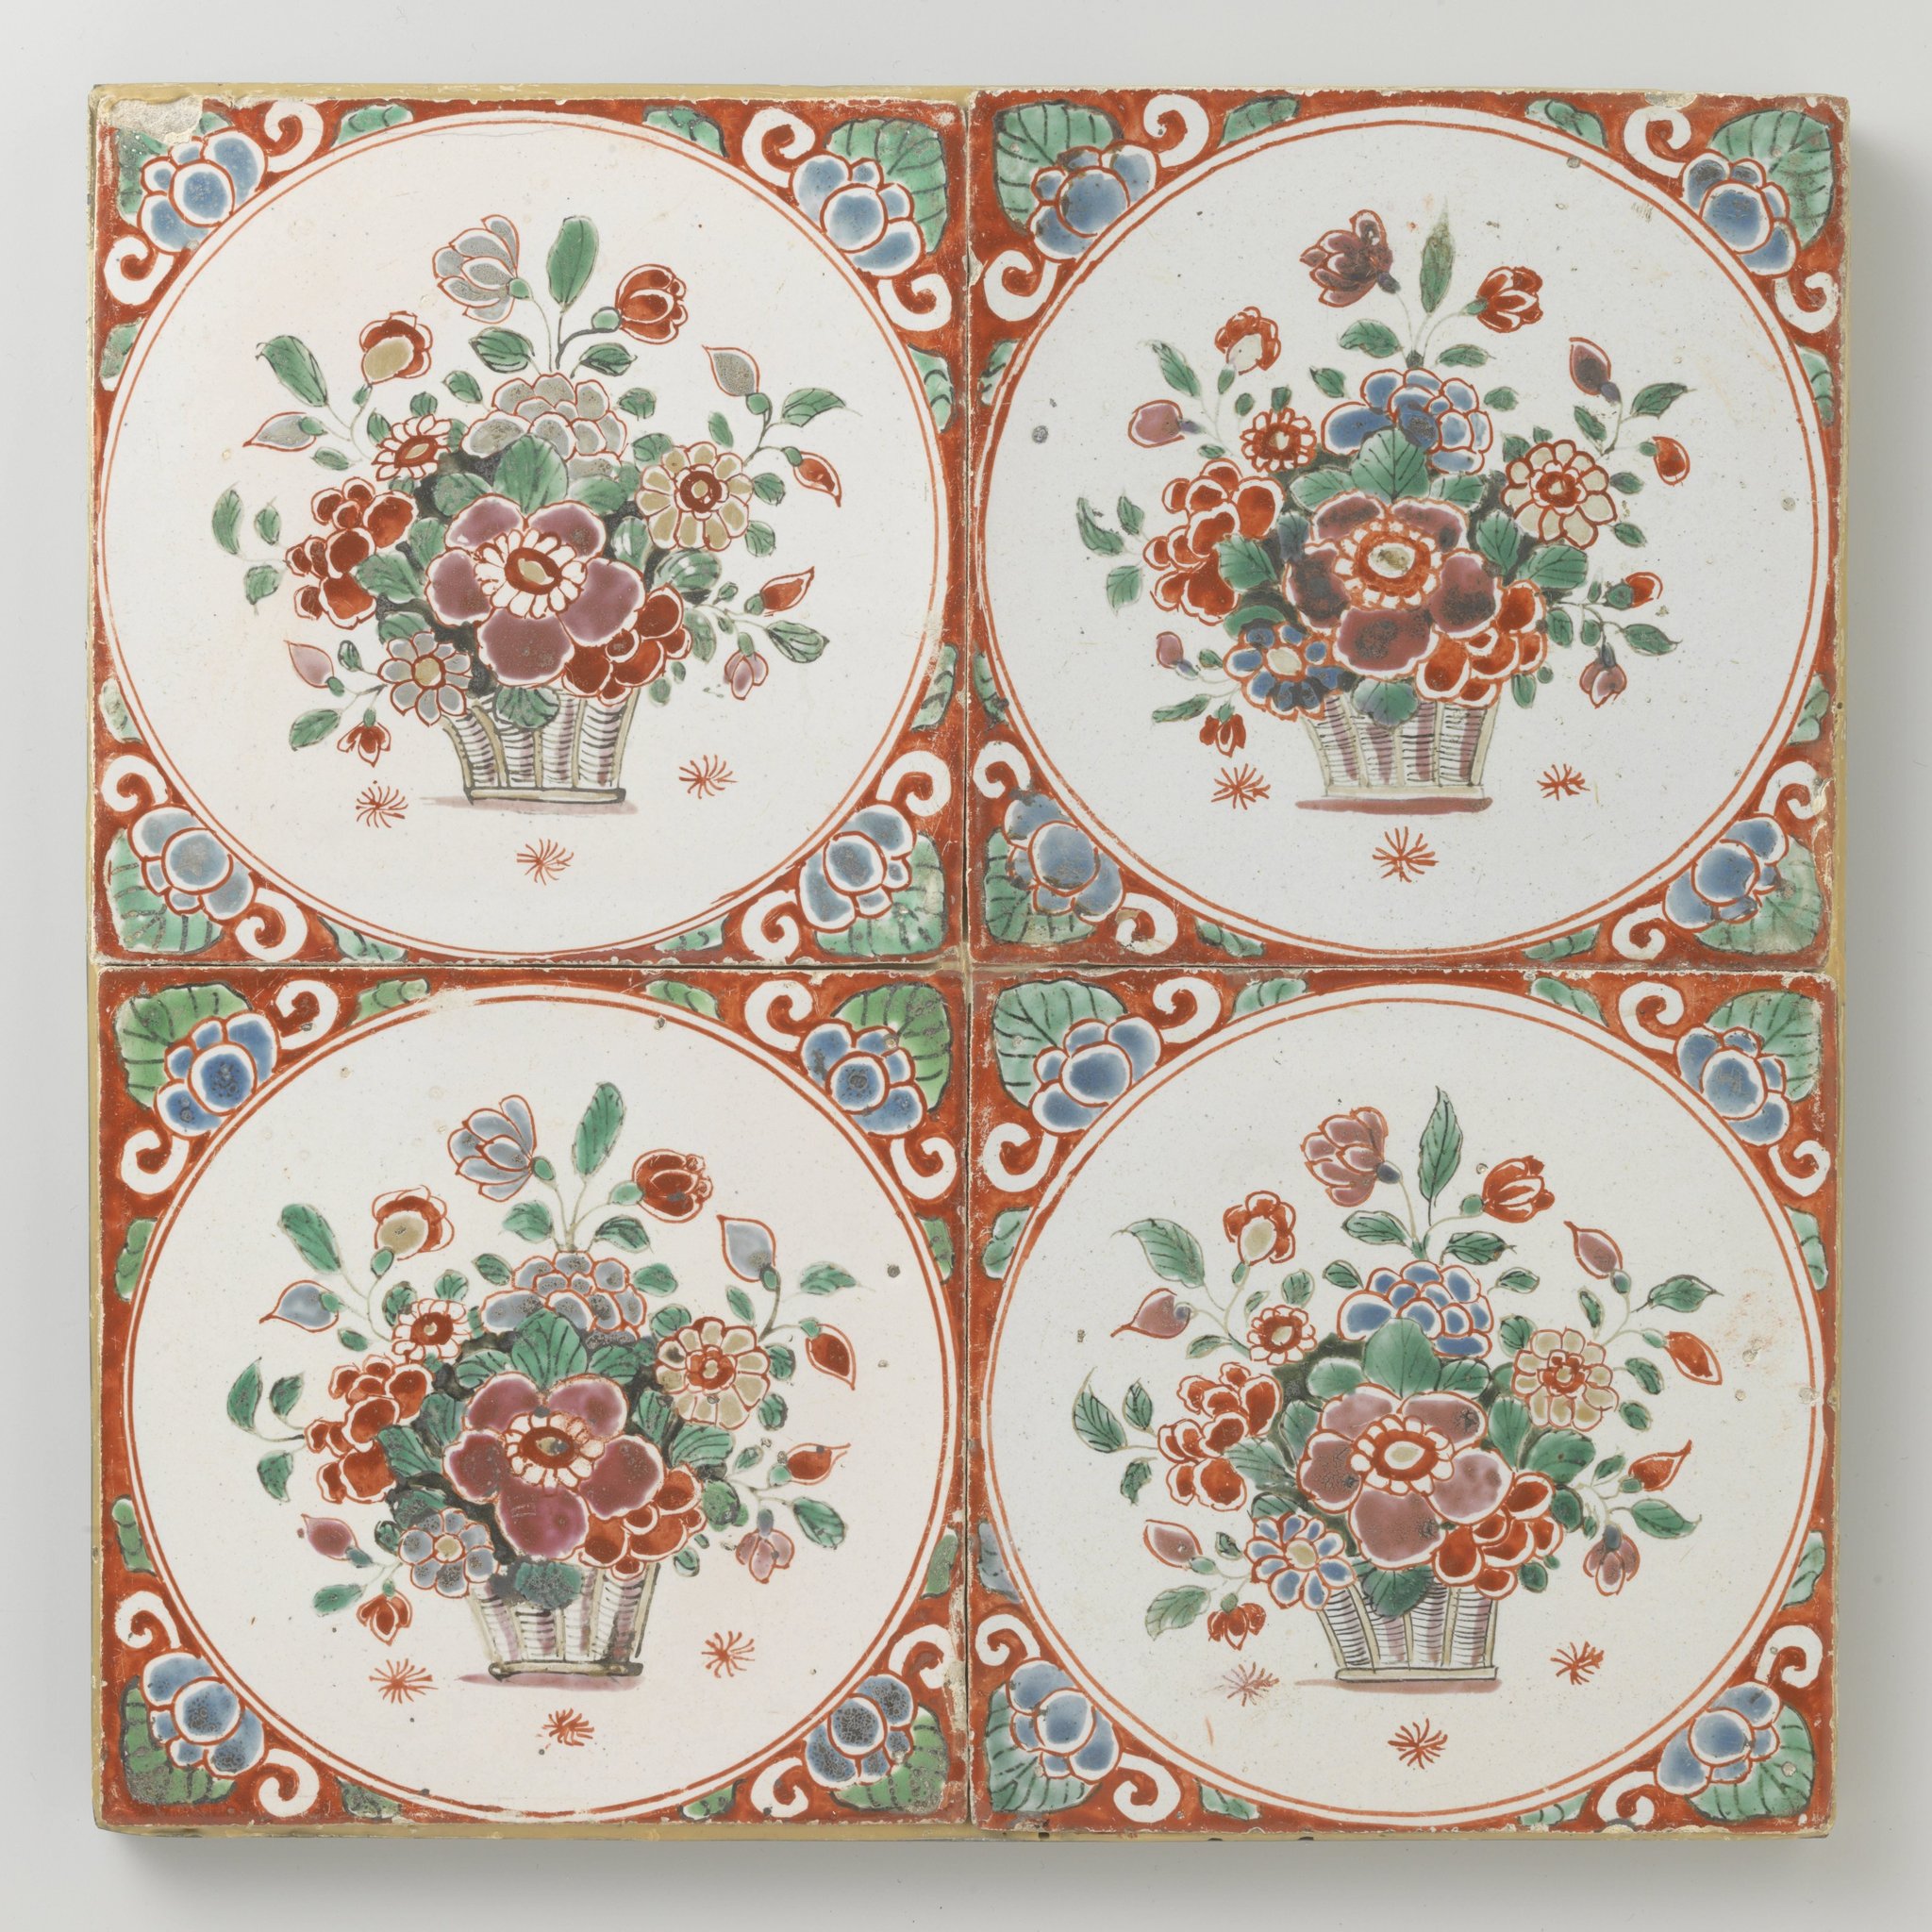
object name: tile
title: Veld van vier tegels met bloemvaas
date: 1720-1750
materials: faience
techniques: kiln, painted, polychromy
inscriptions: collector's mark: ‘verzameling Isaac’, inscription: ‘D’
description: Four tiles. Faience. Delft, c. 1725 - 1750. Given by Arthur Isaac, 1955.